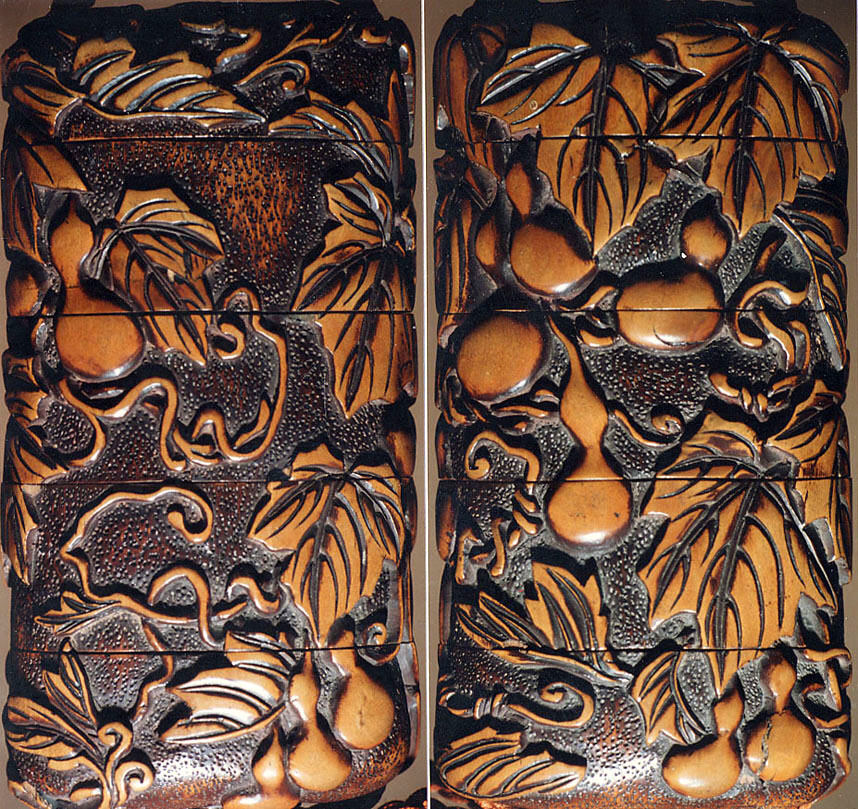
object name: inrō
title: Case (Inrō) with Design of Gourd Vine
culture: japanese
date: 1801-1900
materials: wood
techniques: carving, incising, relief, stain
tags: fruit,plants,gourds